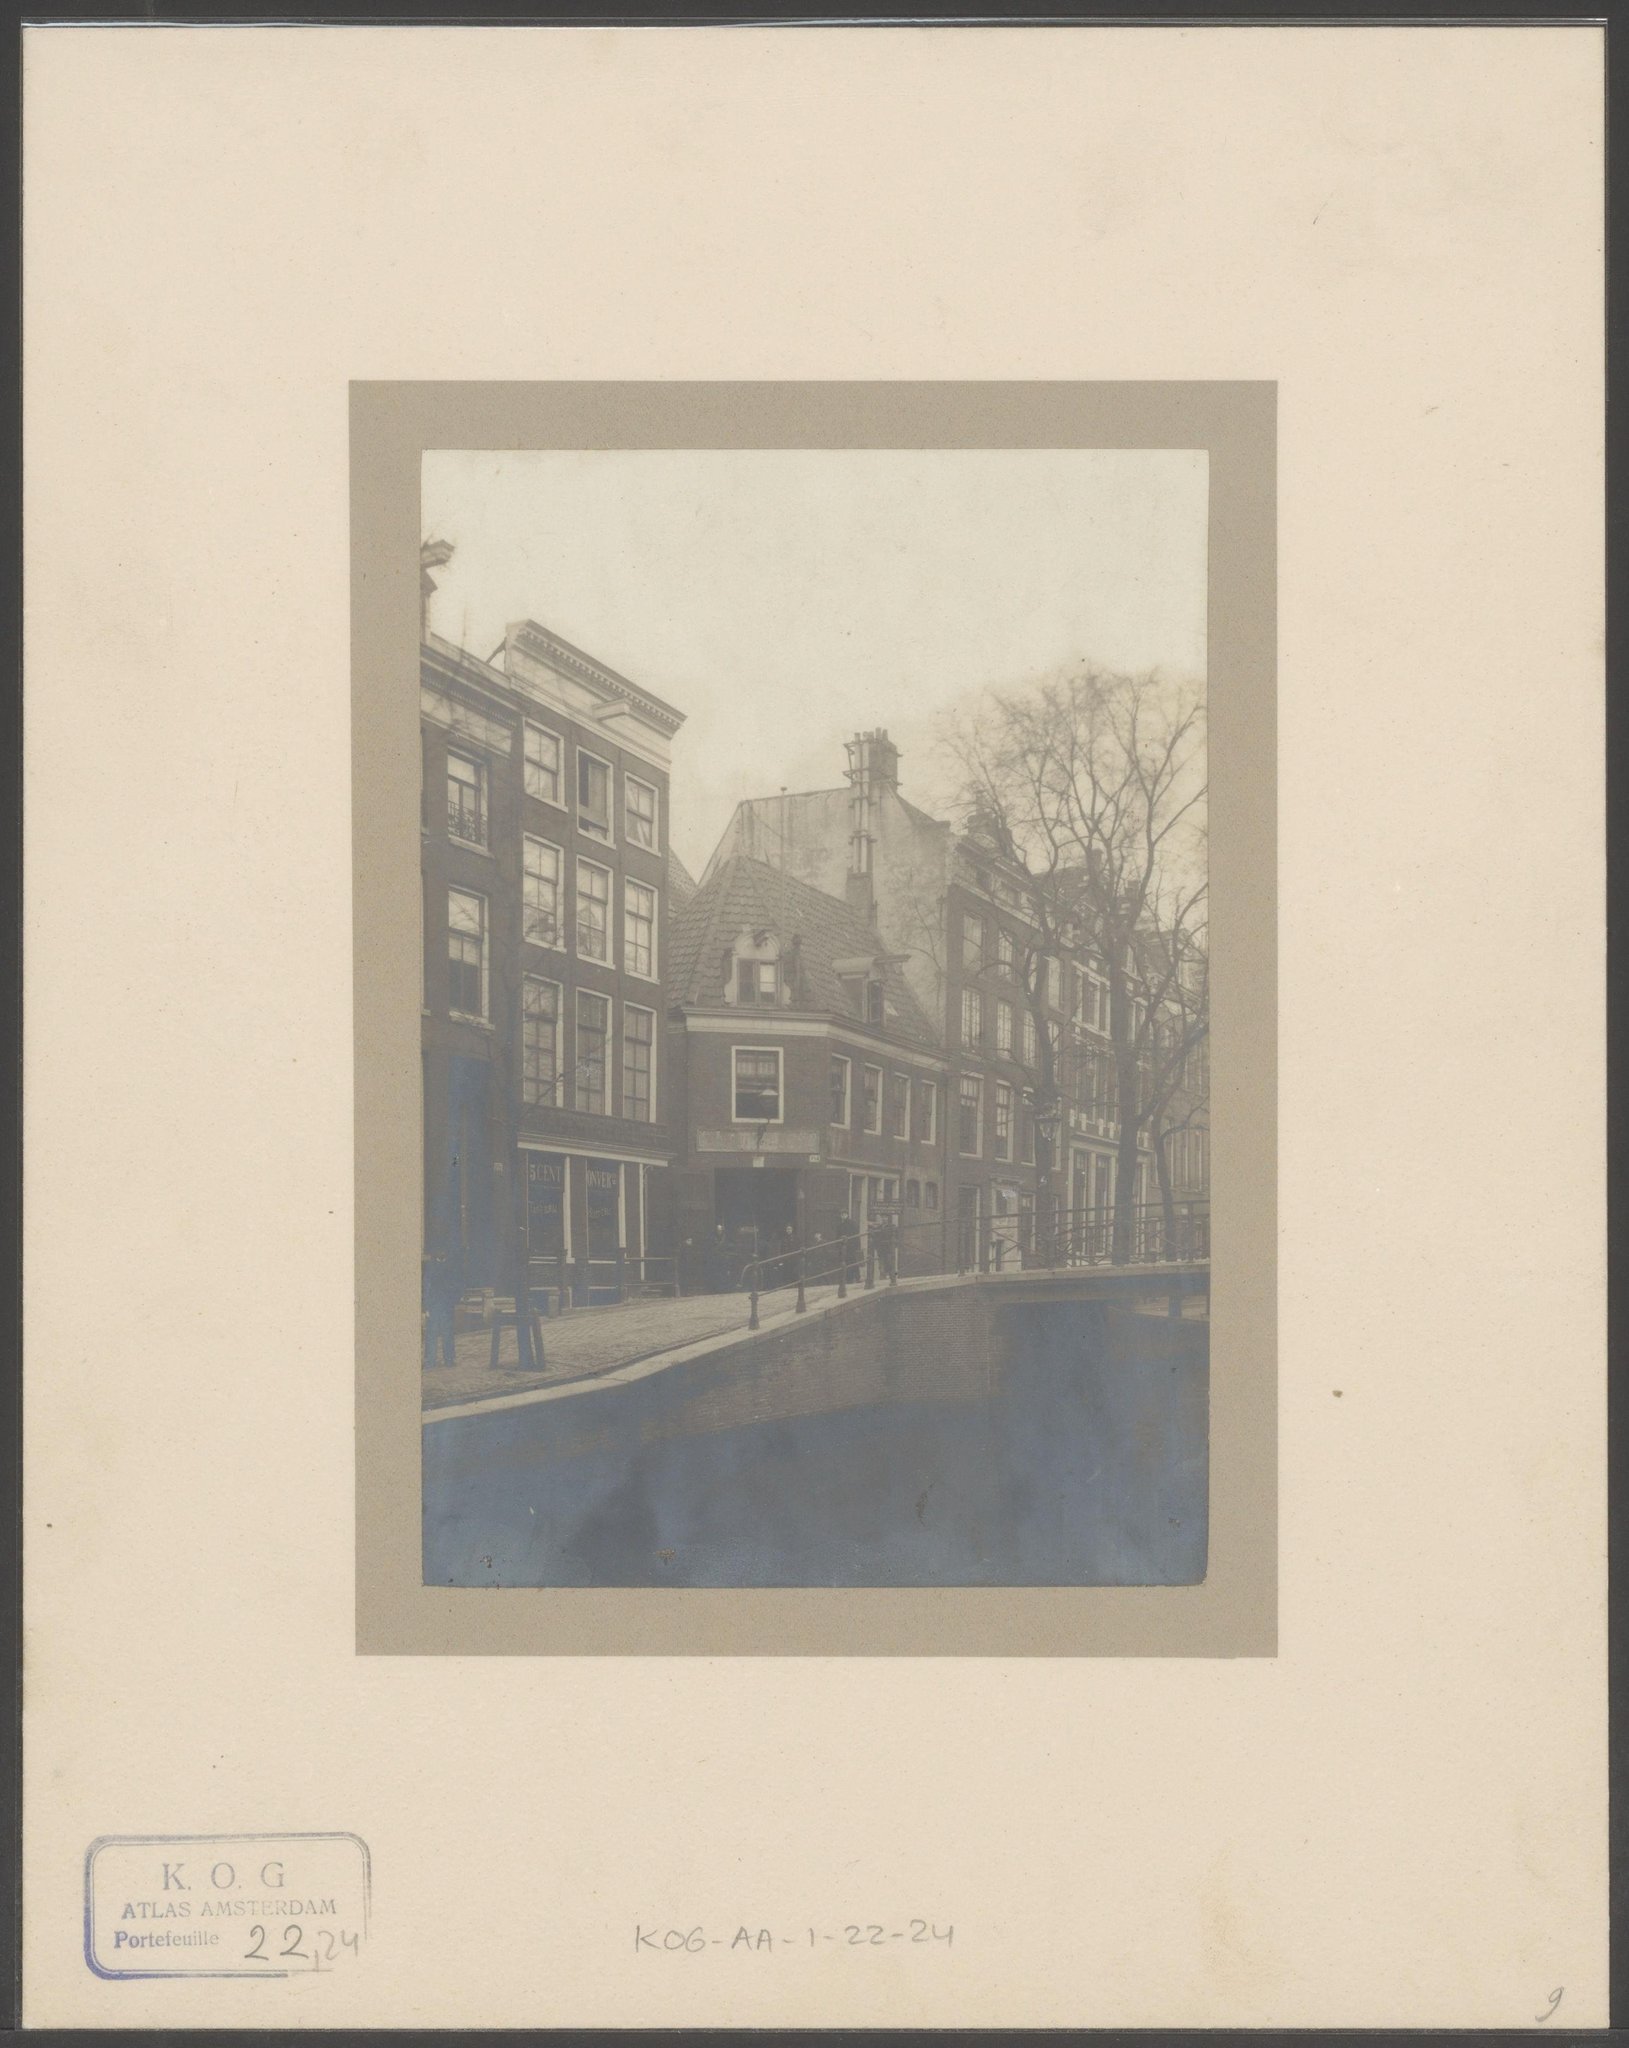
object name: photograph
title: Gezicht op de Oudezijds Achterburgwal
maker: Anonymous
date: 1880-1902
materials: paper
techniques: gelatin silver print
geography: amsterdam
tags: canals, waters (in city), bridge in city across river, canal, etc.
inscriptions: inscription: ‘van S.A. de Flines’, collector's mark: Lugt 1641b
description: Onderwerpsrubriek binnen de Atlas Amsterdam: Gemeentewerken: A. Brandweer.